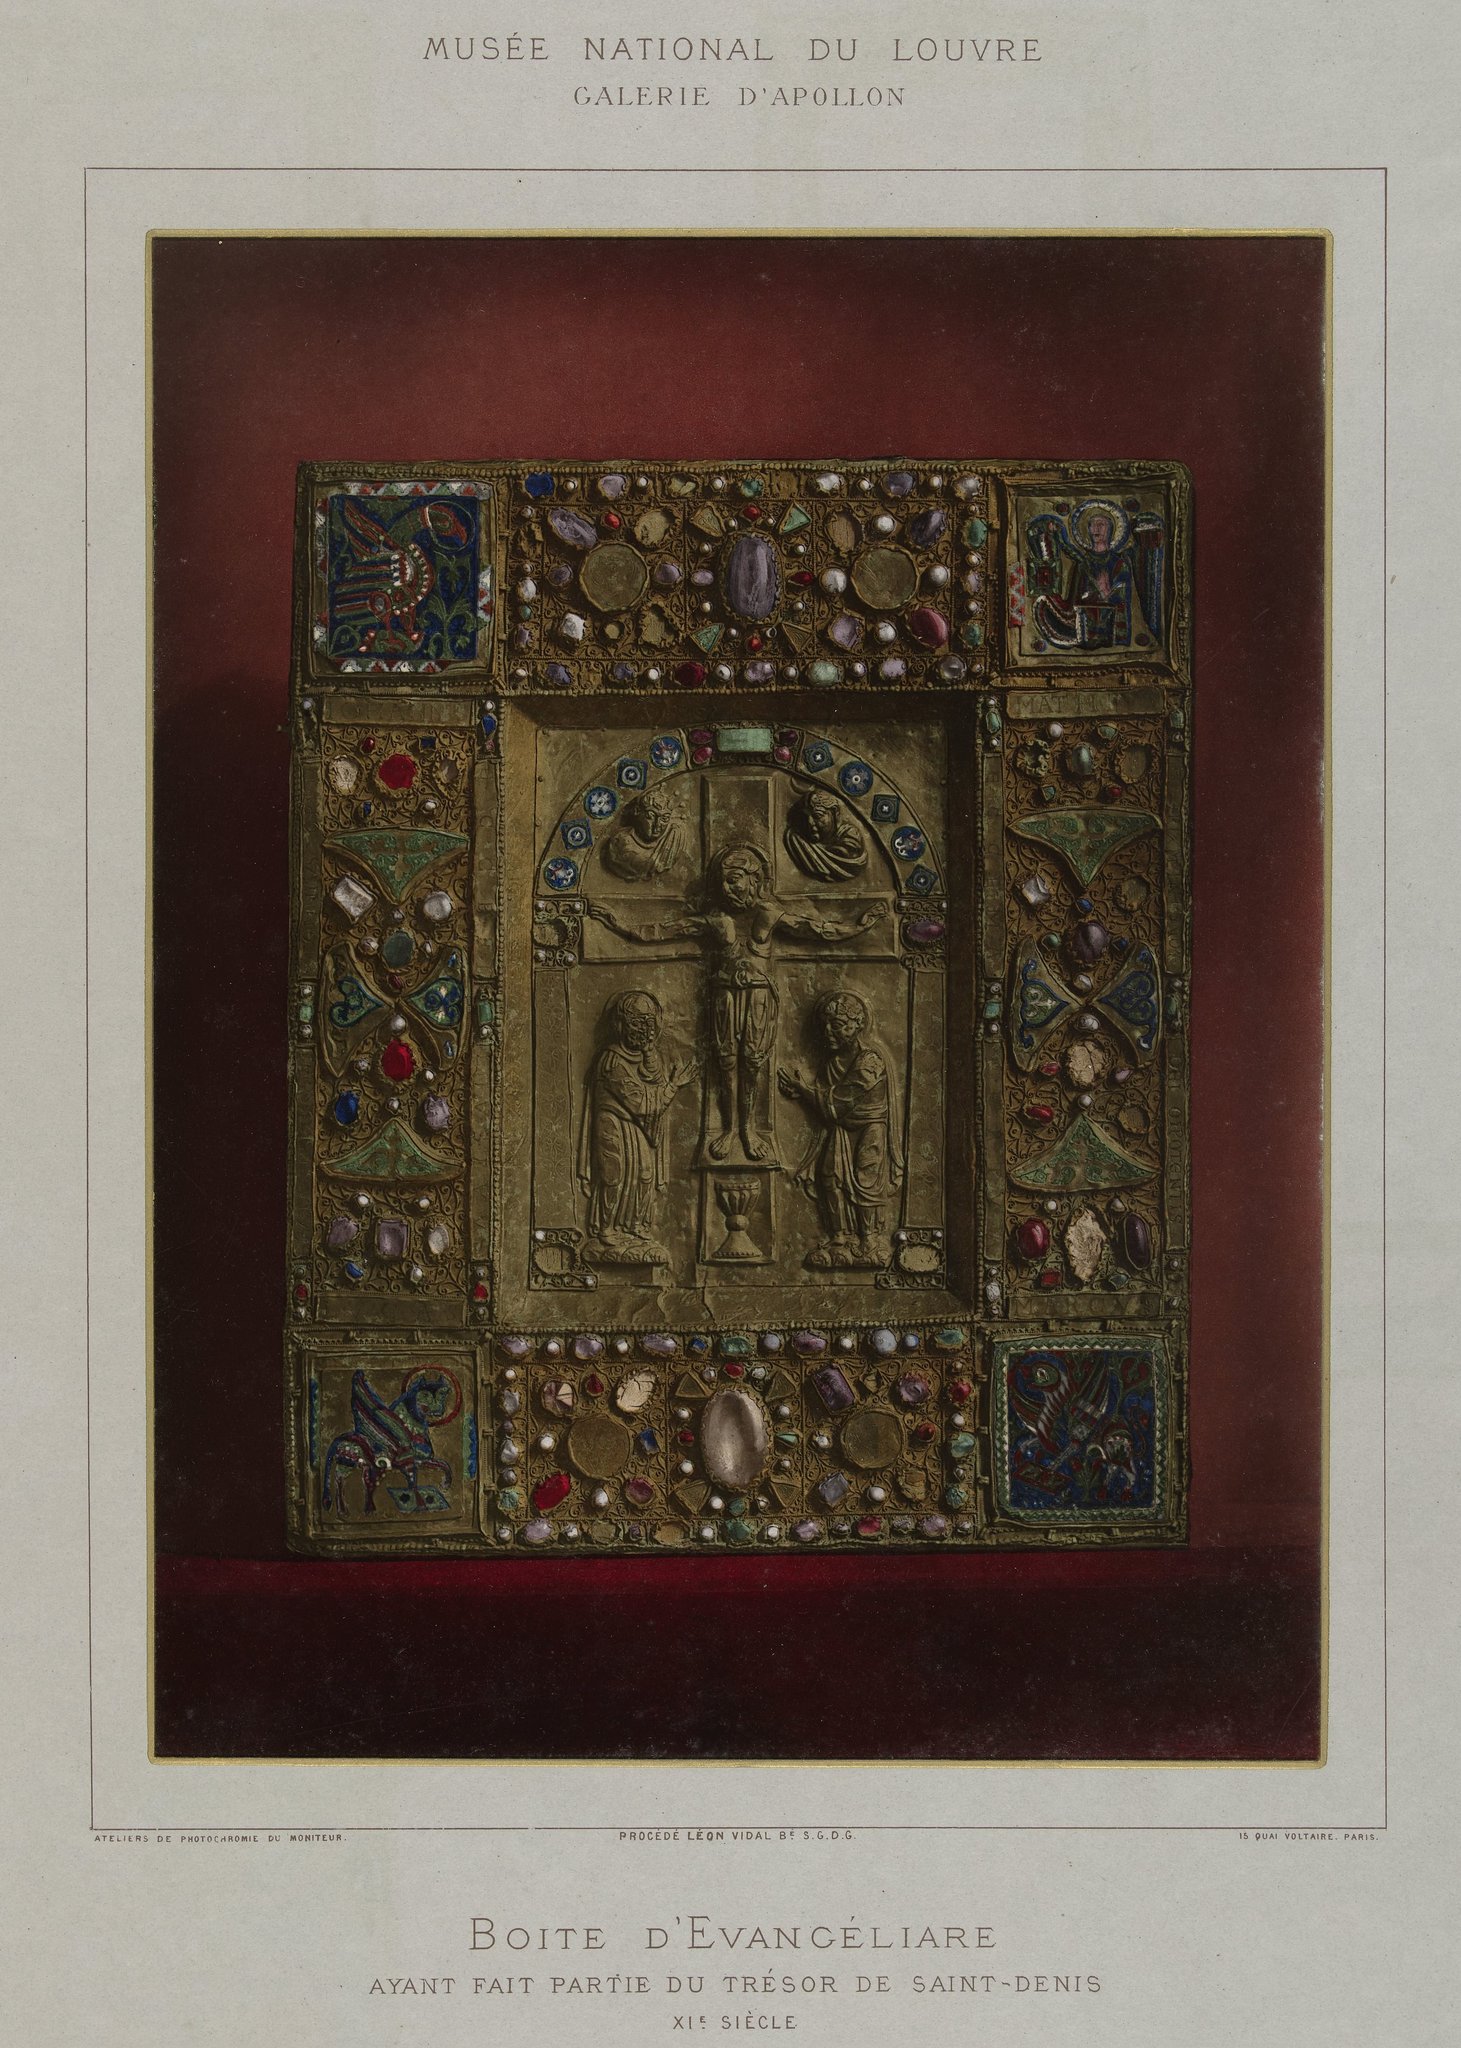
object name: photomechanical print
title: Boite d'Évangéliare ayant fait partie du trésor de Saint-Denis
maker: Anonymous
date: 1874-1880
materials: cardboard, paper, photographic process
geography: paris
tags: crucified christ with other persons, gem, gemstone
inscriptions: inscription: ‘Ateliers de Photochromie du Moniteur/ Procédé Léon Vidal Bé. S.G.D.G./ 15 Quai Voltaire, Paris’, title: ‘Musée National du Louvre/ Galerie d'Apollon/ Boite d'Evangéliare/ ayant fait partie du trésor de Saint-Denis/ XIe siècle’